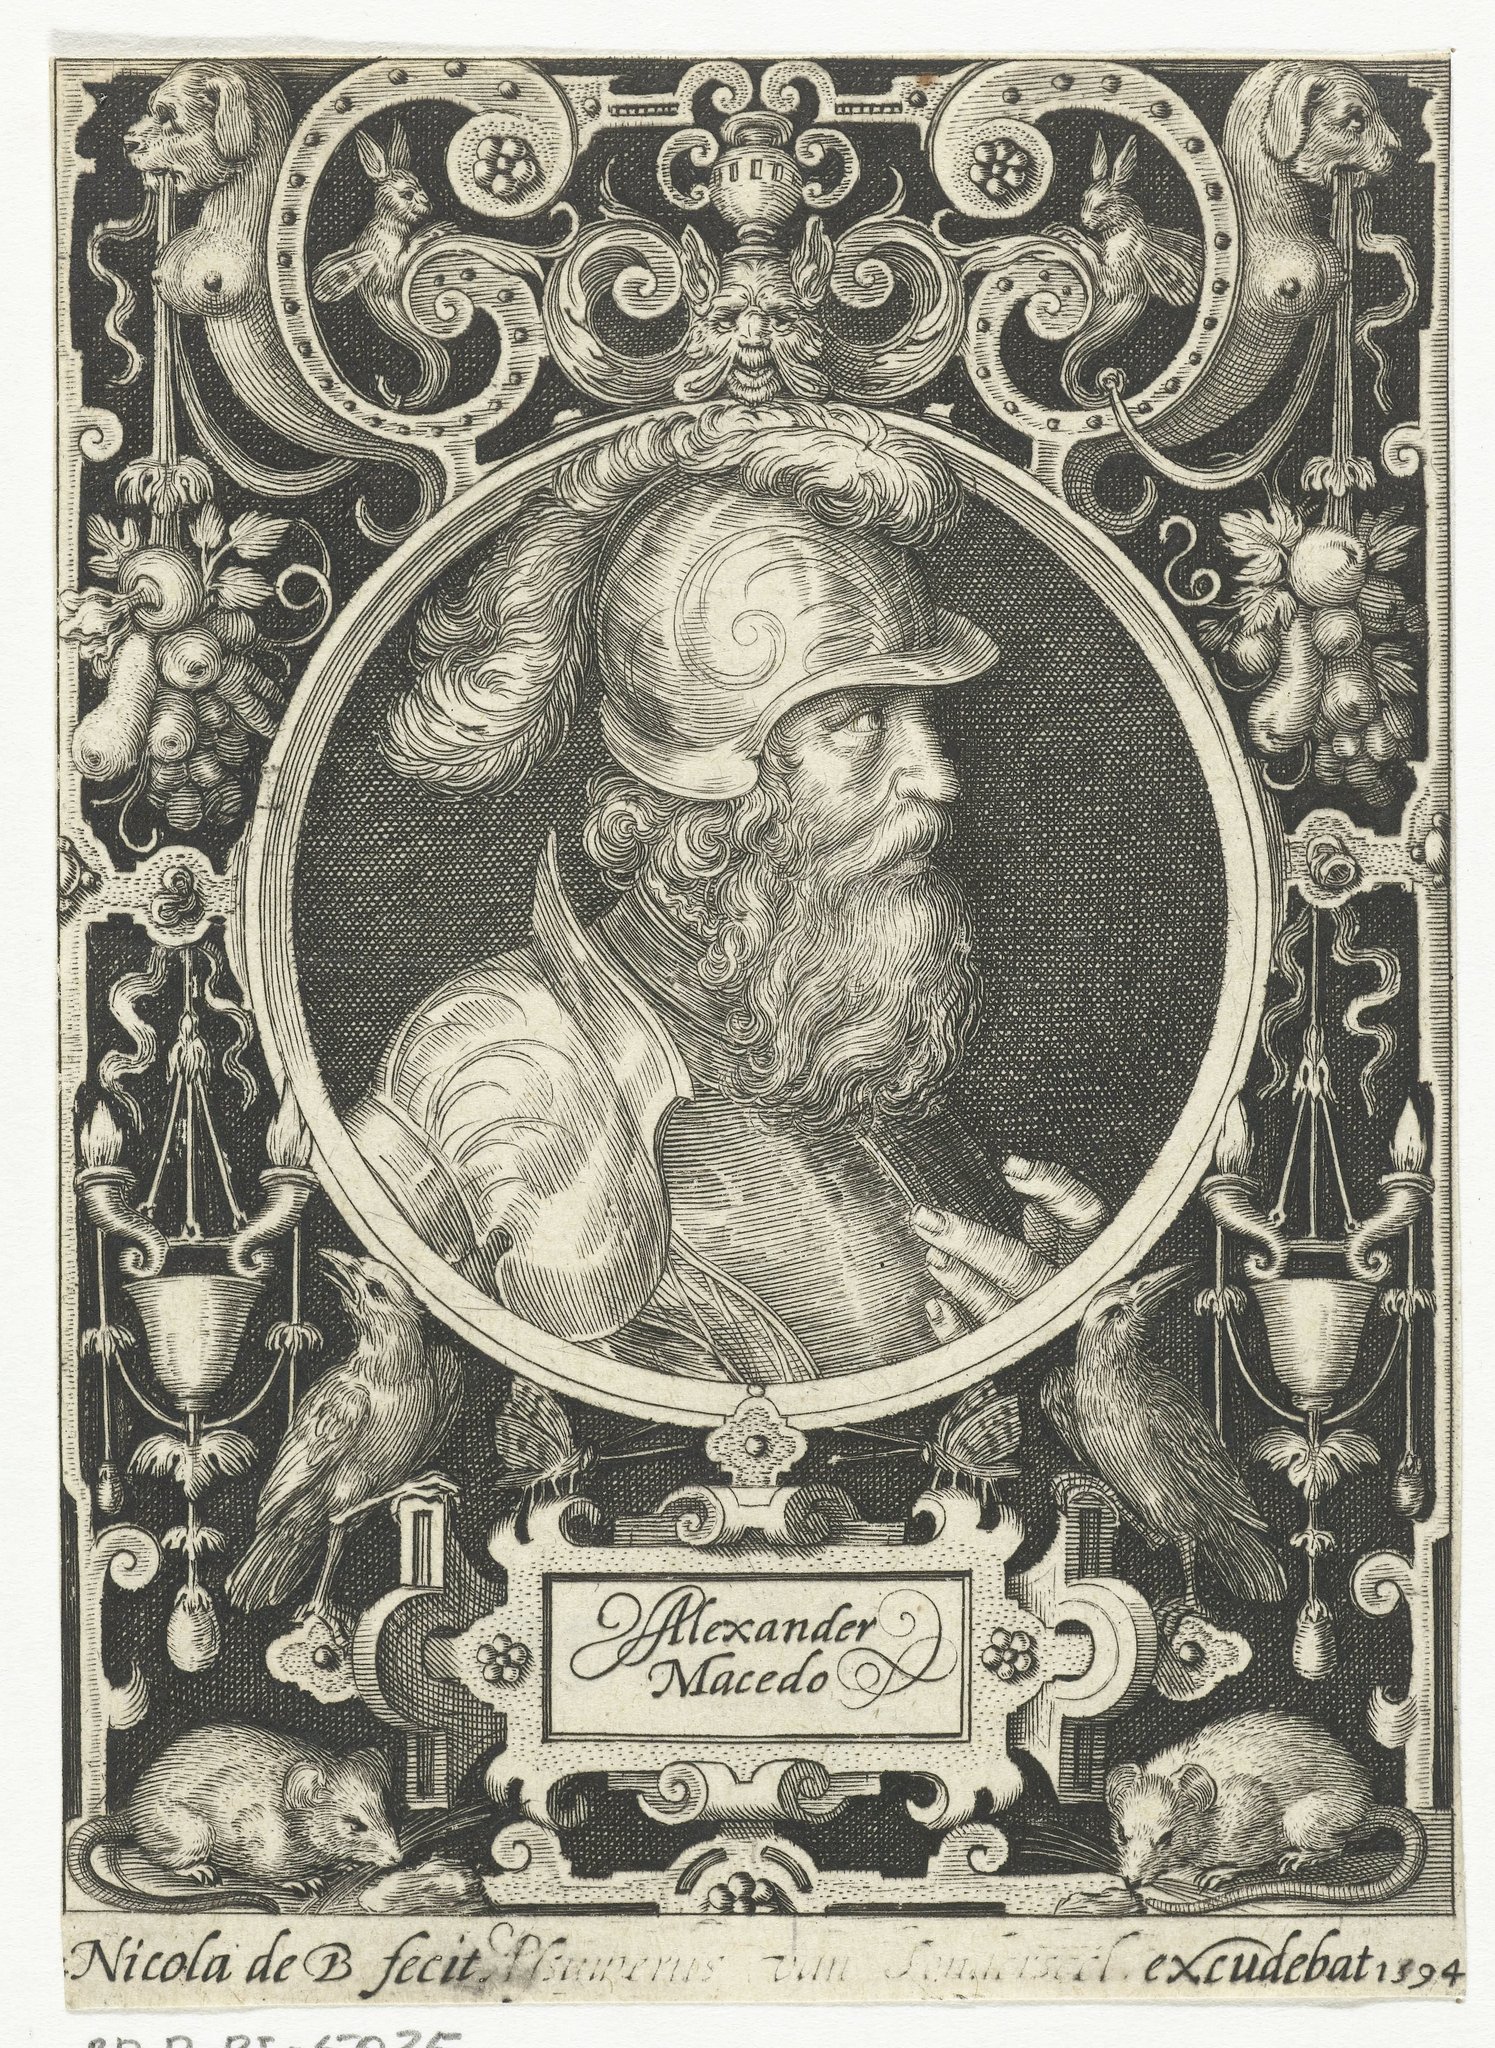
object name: print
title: Portret van Alexander de Grote in medaillon binnen rechthoekige omlijsting met ornamenten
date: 1594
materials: paper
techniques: engraving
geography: netherlands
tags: alexander (one of the nine worthies)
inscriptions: collector's mark: Lugt 2228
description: Prent uit serie van negen prenten met de negen besten. De op de drukplaat verwijderde naam van uitgever Assuerus van Londerseel is met enige moeite nog leesbaar op deze druk, vergelijk andere prenten uit de serie met zijn naam die duidt op de eerste staat.